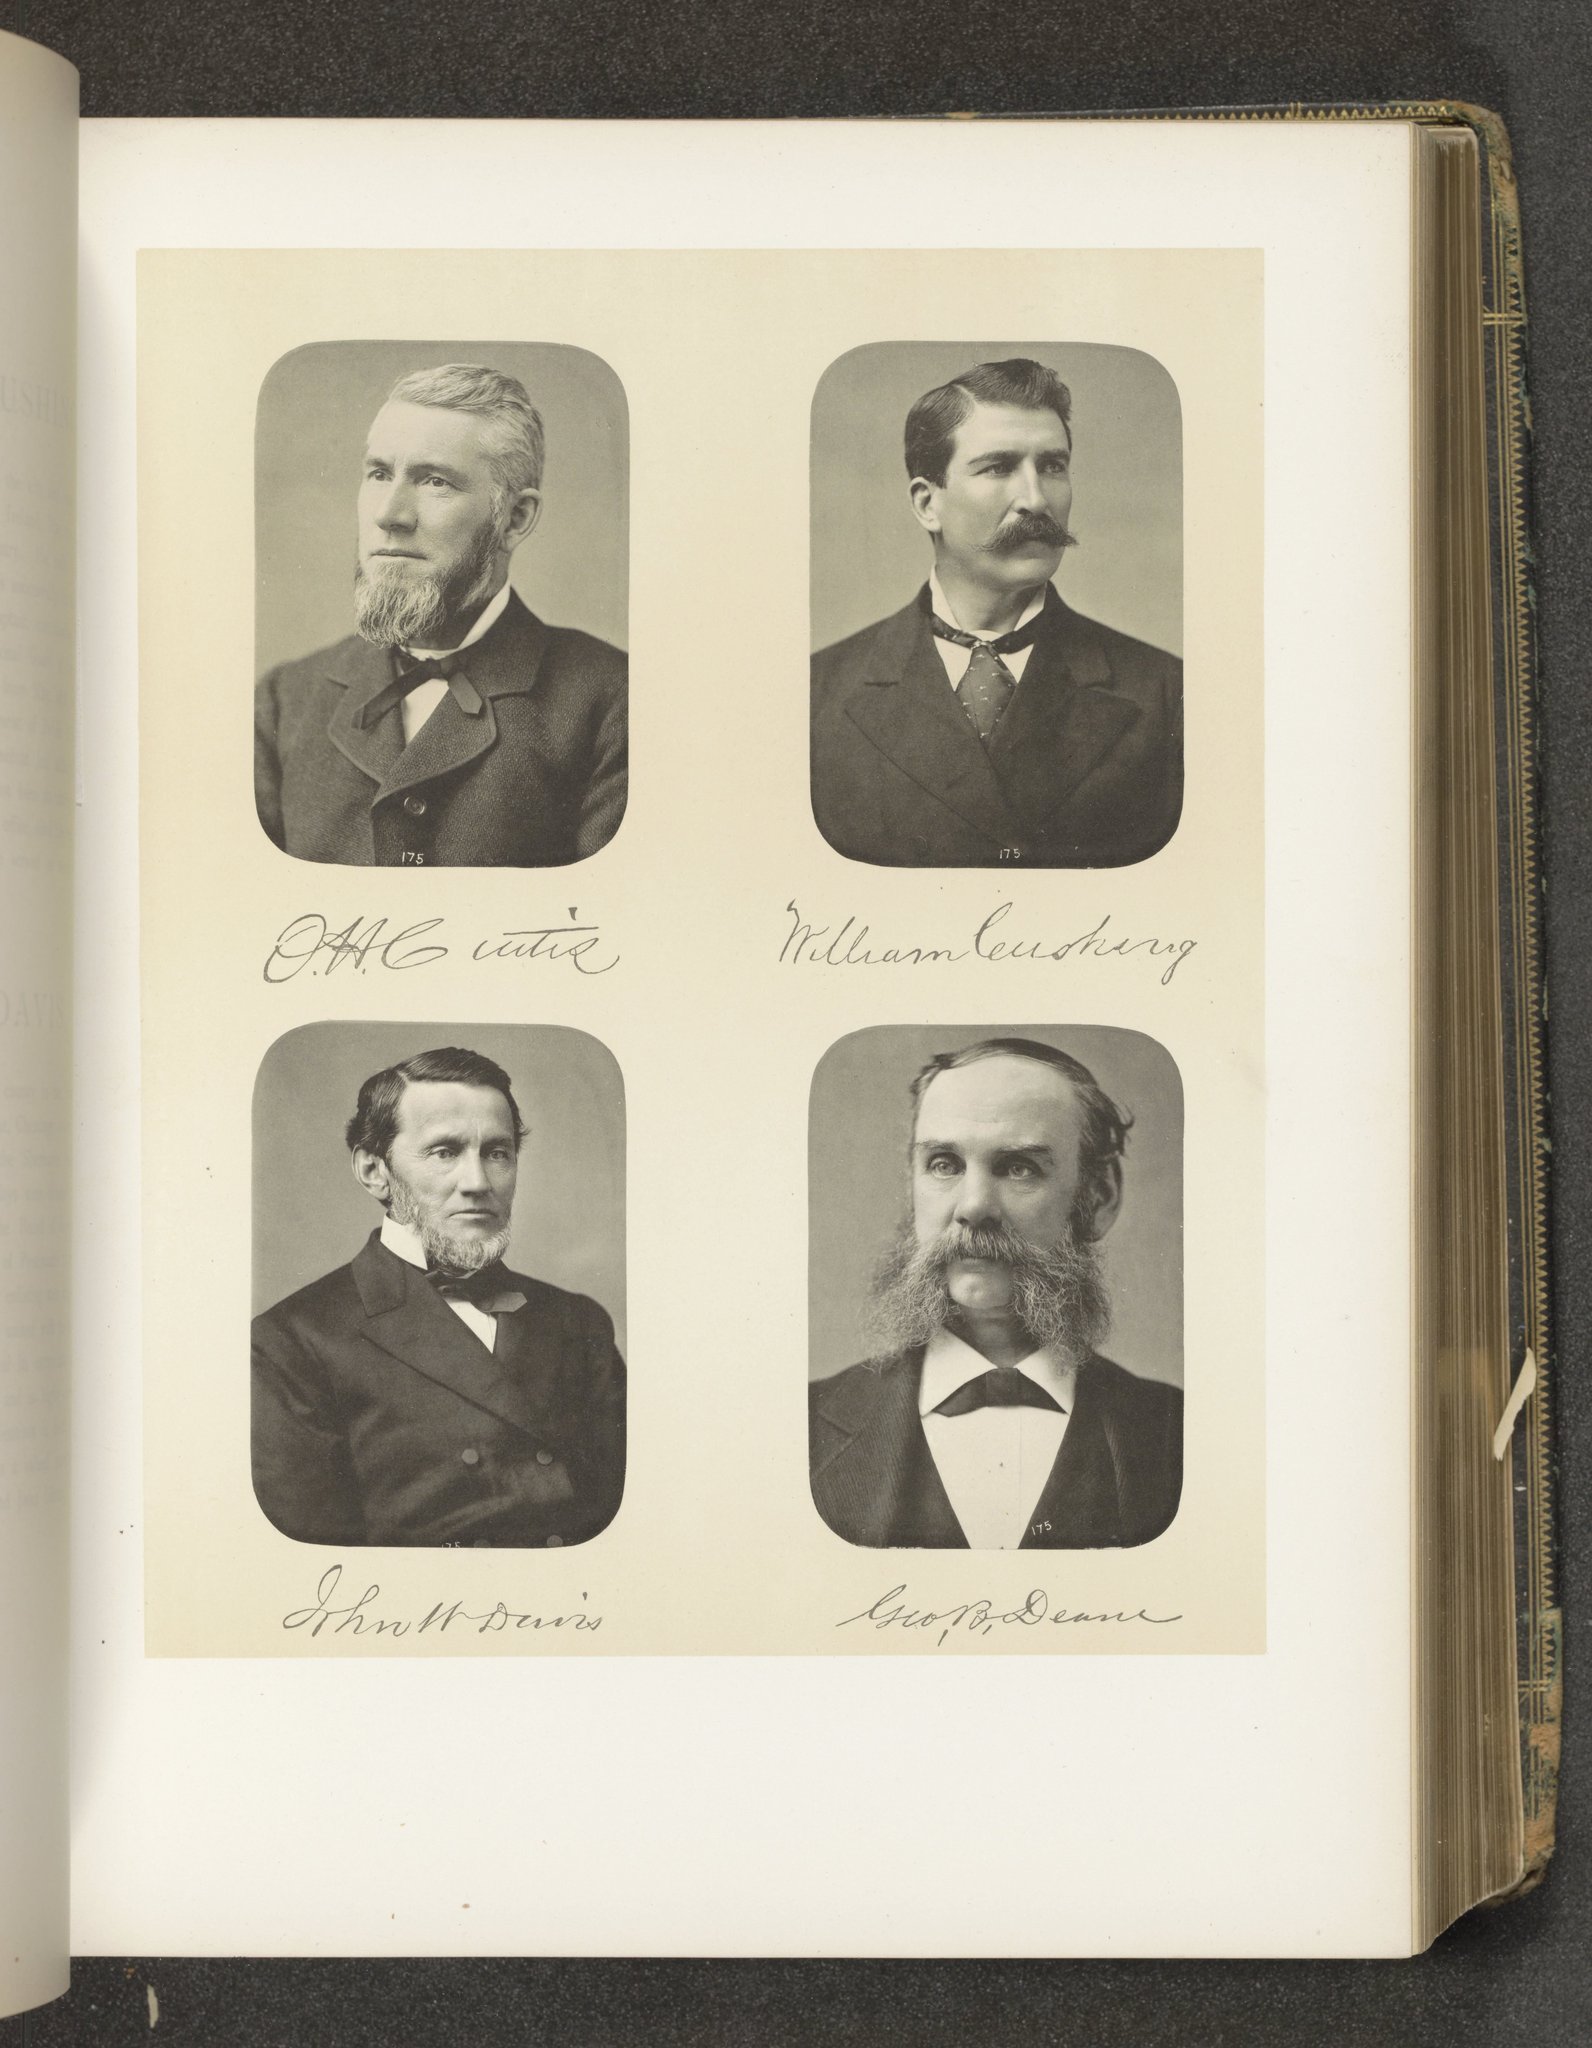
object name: photomechanical print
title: Portretten van vier leden van het Lagerhuis van de staat New York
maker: Anonymous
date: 1872-1882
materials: paper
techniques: photograph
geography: united states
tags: historical persons (portraits and scenes from the life) (+ head (and shoulders) (portrait))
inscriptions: number: ‘175’, annotation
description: Linksboven Oscar H. Curtis, rechtsboven William Cushing, linksonder John W. Davis, rechtsonder George B. Deane.